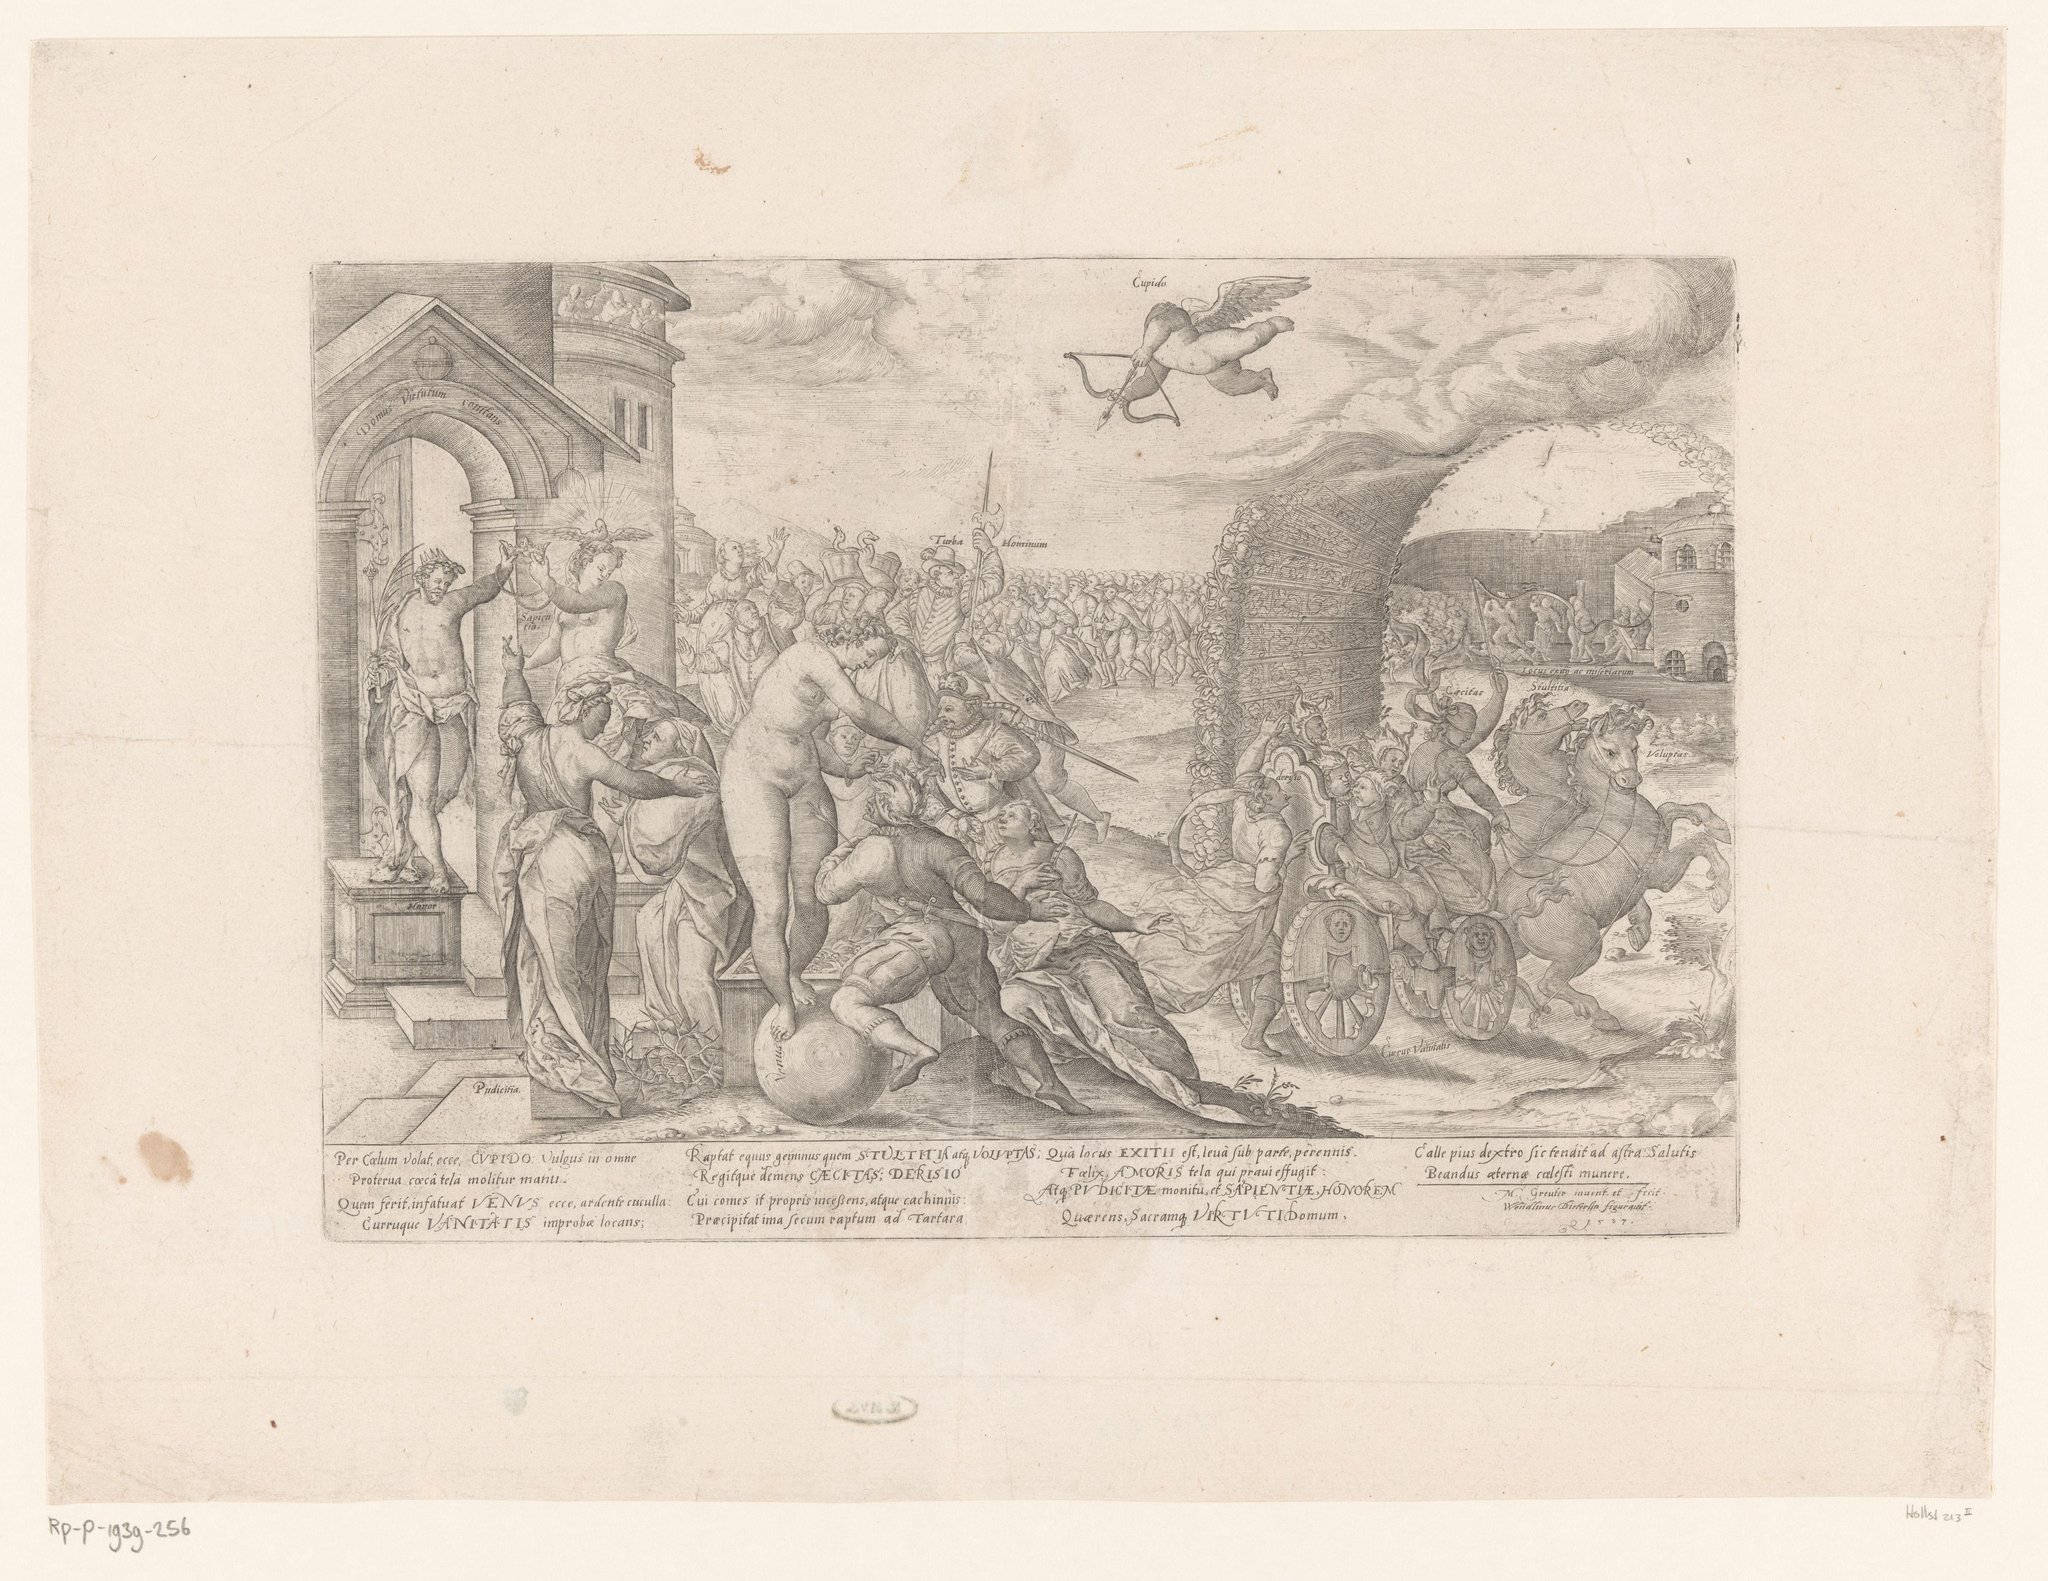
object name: print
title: Allegorie op de macht van Venus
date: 1587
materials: paper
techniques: engraving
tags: voluptuousness, pleasure, 'voluptas' ~ one of the seven gifts of the body, honour, 'honor' ~ one of the seven gifts of the soul, wisdom; 'sapienza', 'sapienza humana', 'sapienza vera' (ripa), 'castità ', 'pudicitia', 'vergogna honesta' (ripa), folly, foolishness; 'pazzia', 'sciocchezza', 'stoltitia' (ripa), specific aspects of cupid, specific aspects, allegorical aspects of venus; venus as patroness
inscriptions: collector's mark: Lugt 2228, collector's mark: Lugt 2760